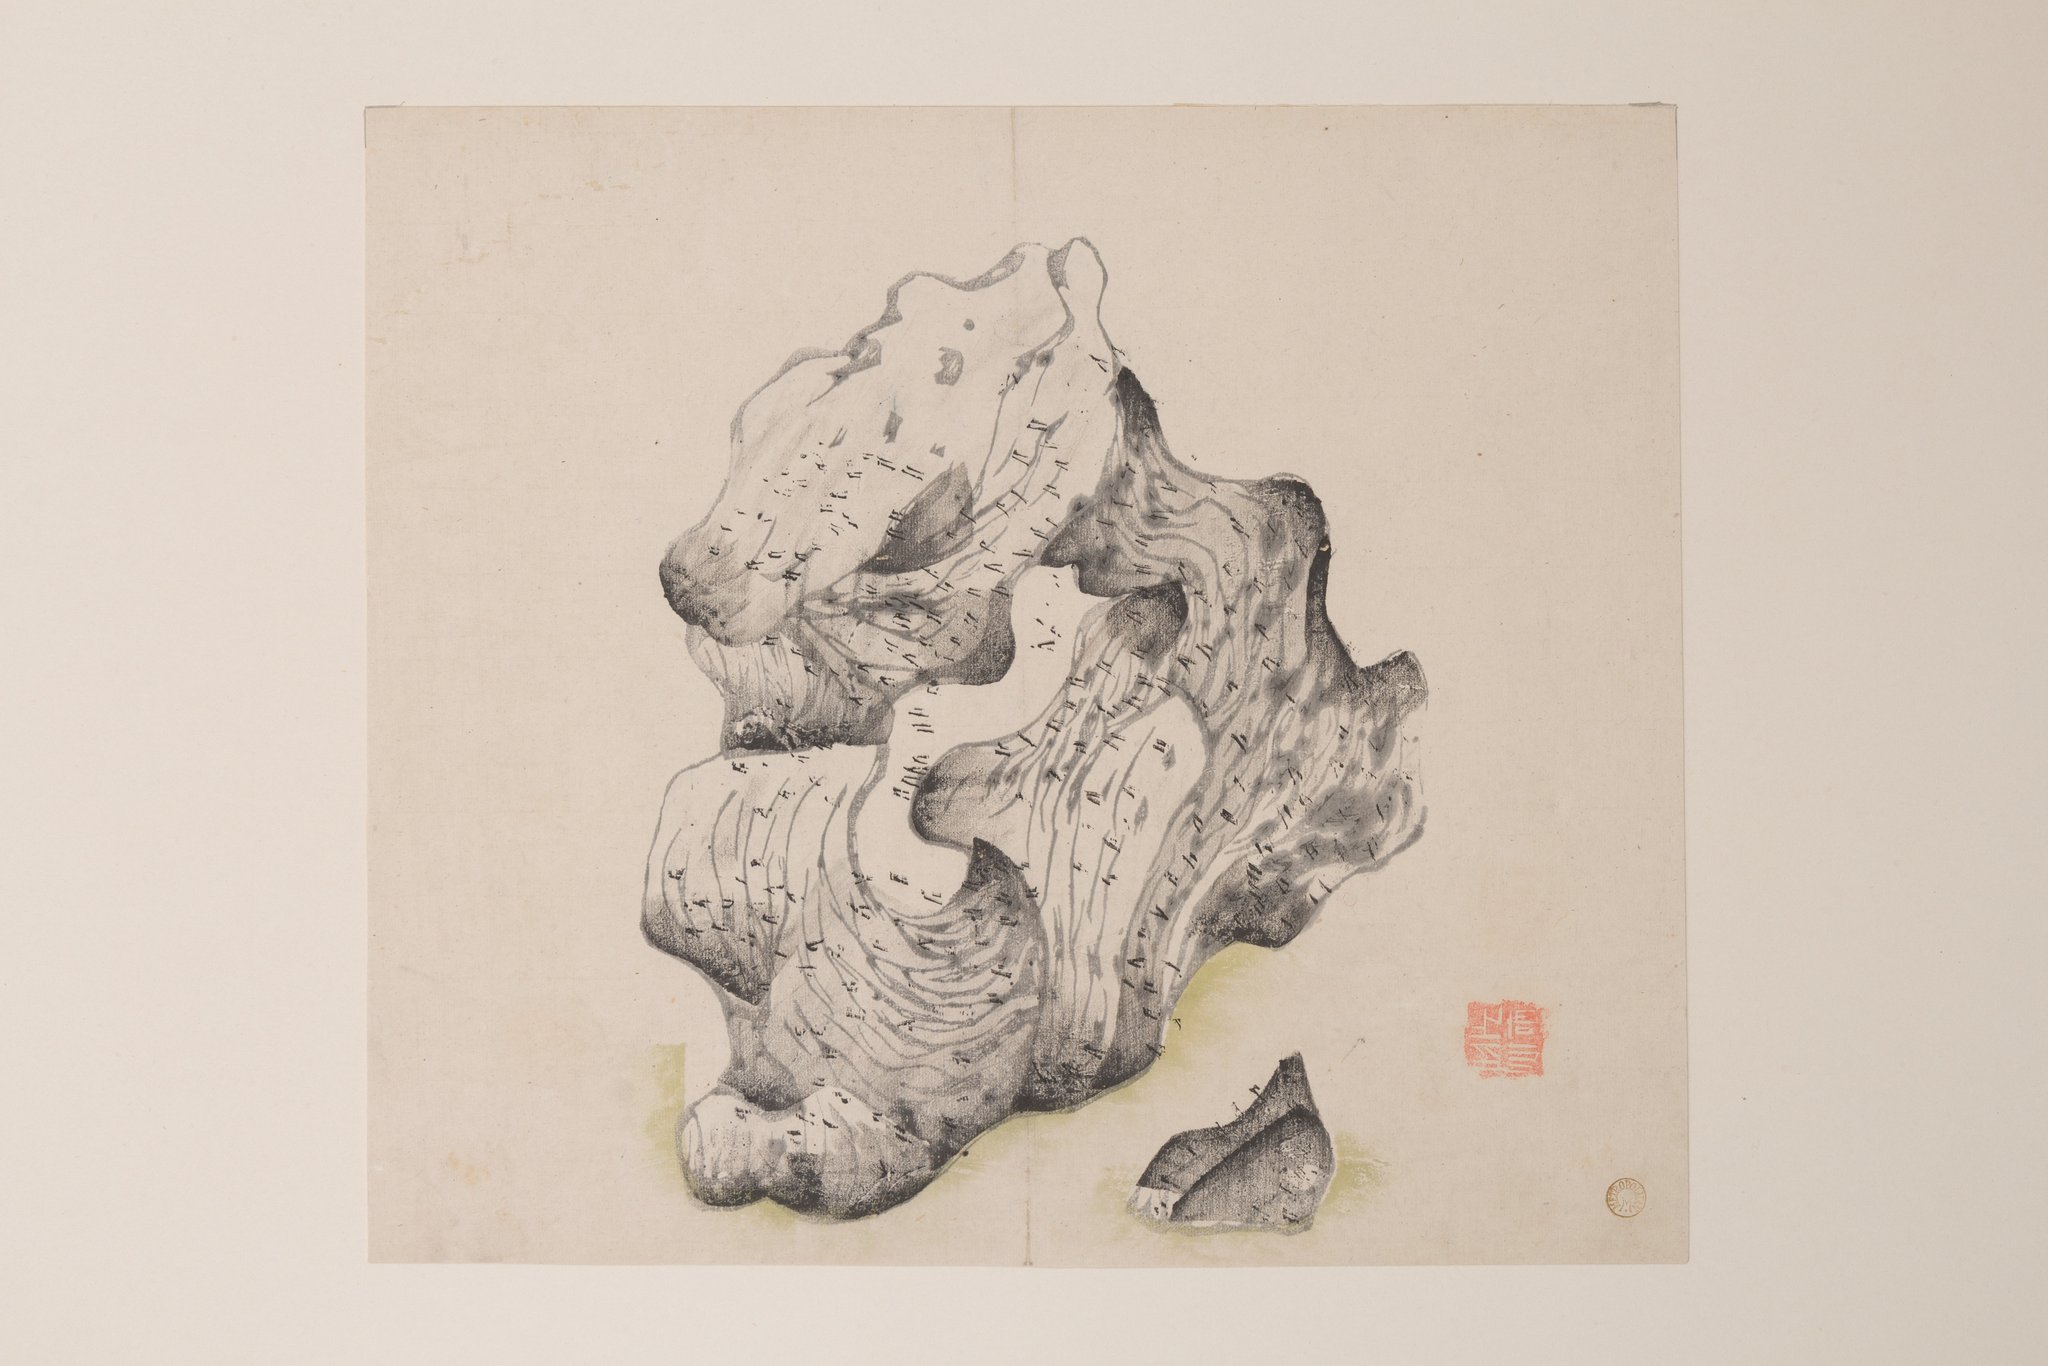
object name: print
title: Page from the Ten Bamboo Studio Manual of Painting and Calligraphy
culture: chinese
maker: hu zhengyan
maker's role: artist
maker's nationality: chinese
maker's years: 1584-1634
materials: ink, paper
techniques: printing